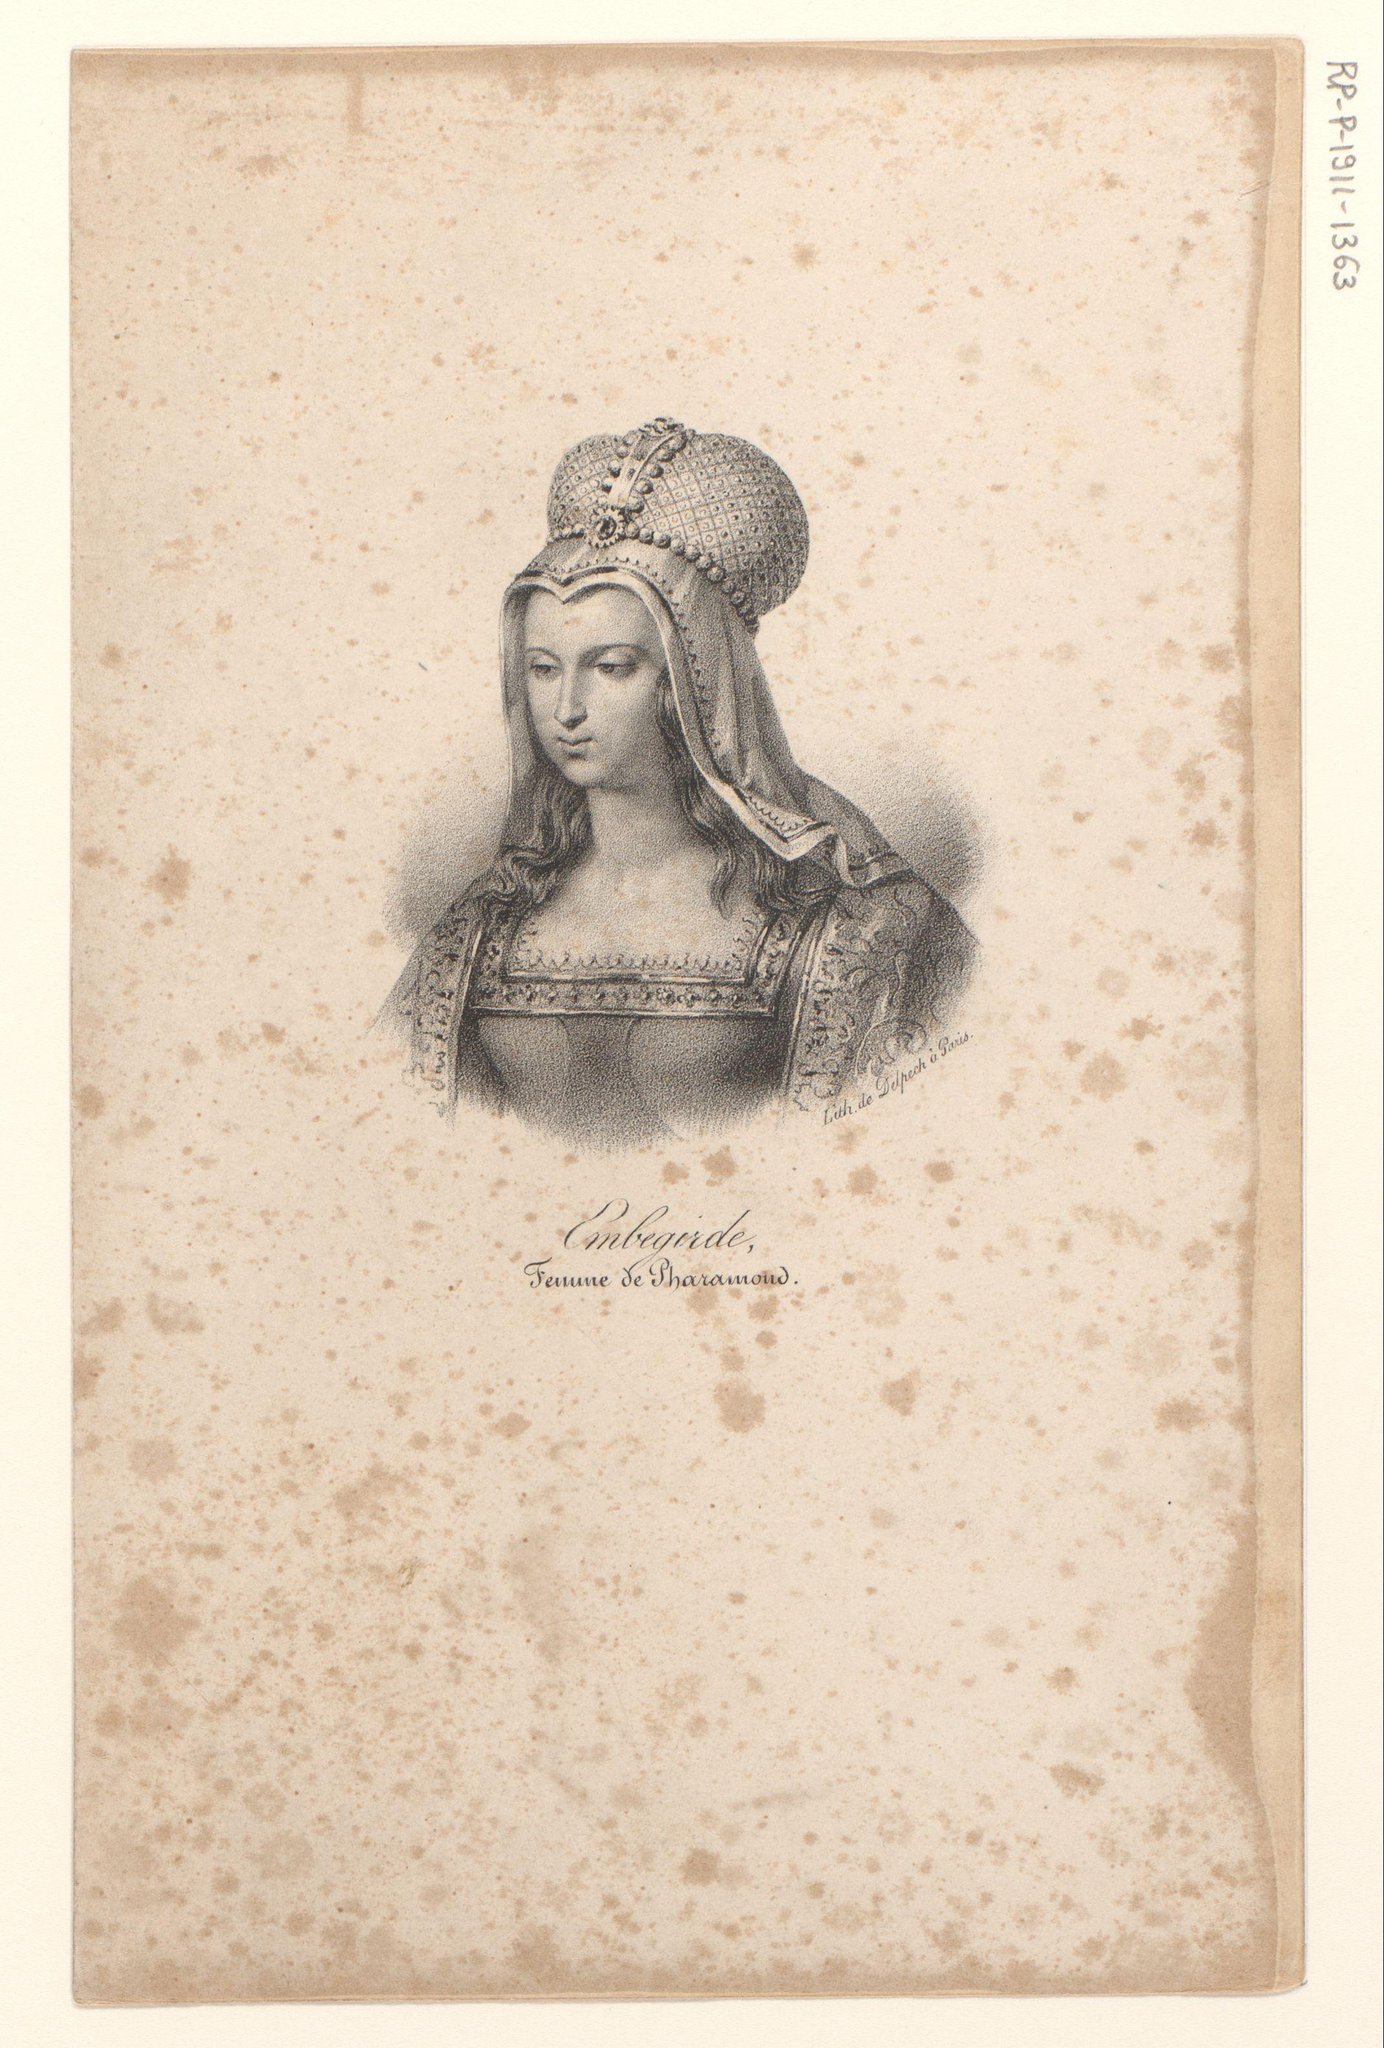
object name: print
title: Embegirde, femme de Pharamond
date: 1818-1842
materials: paper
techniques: lithograph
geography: paris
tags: historical persons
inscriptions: collector's mark: Lugt 2228a